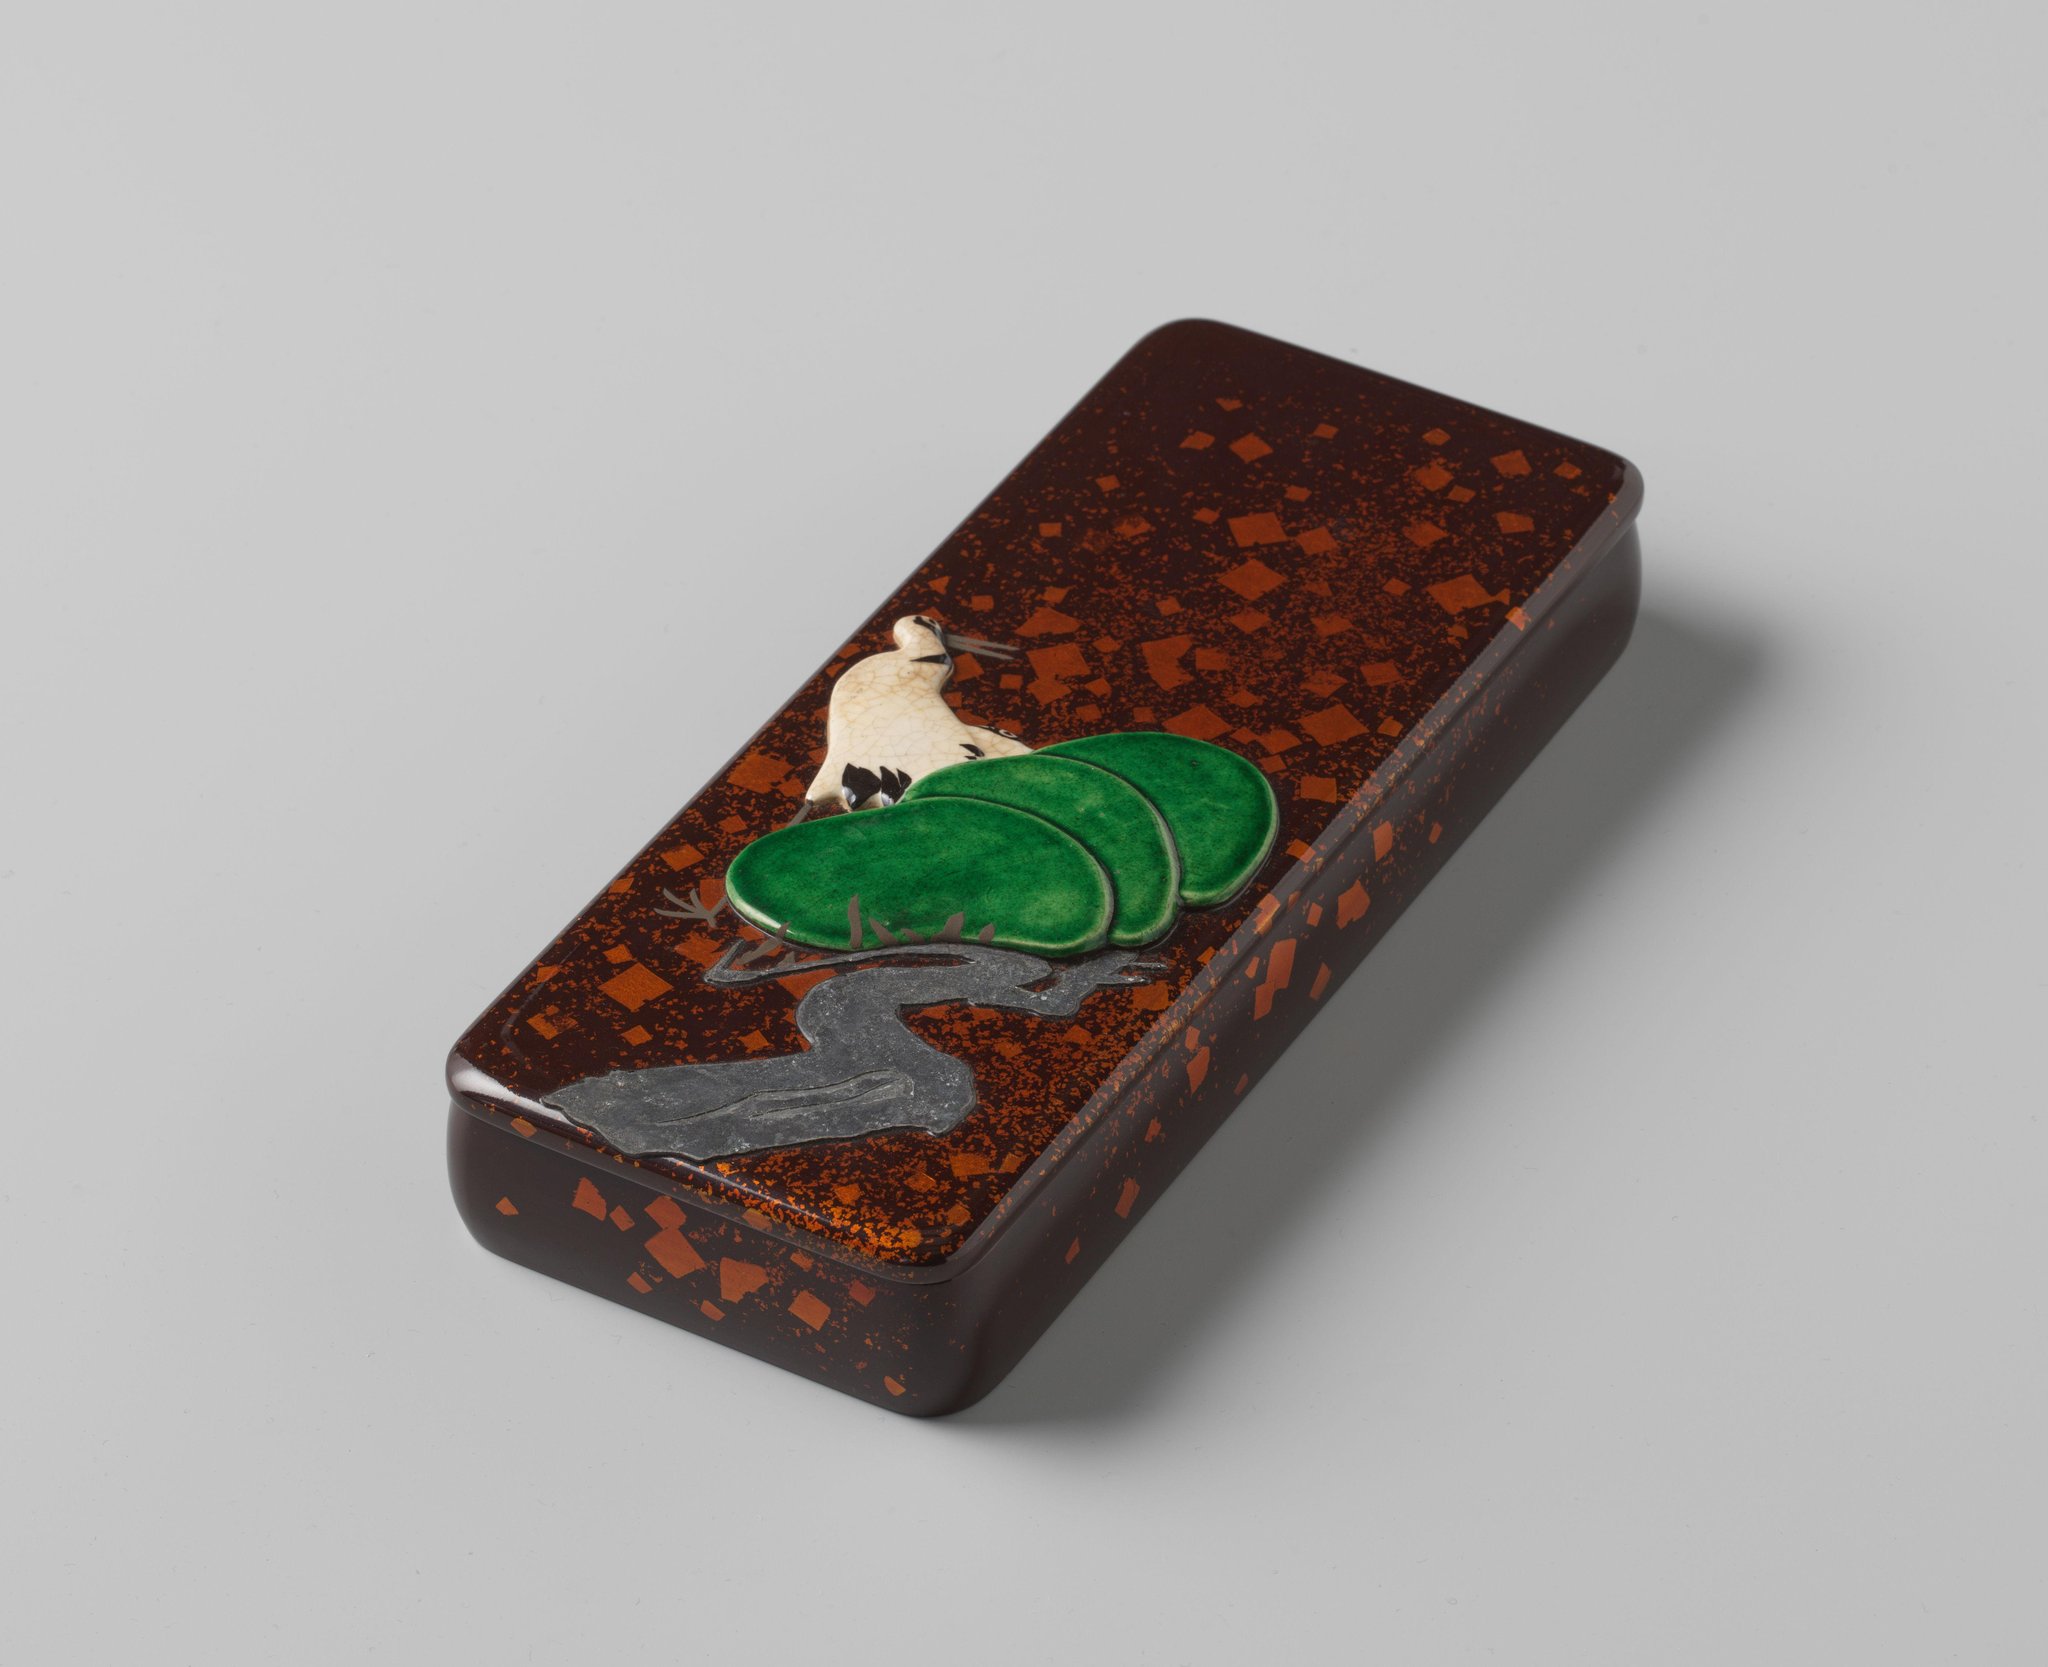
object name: schrijfdoos, schrijfcassette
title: Writing box ‘A Pair of Cranes in an Old Pine Tree’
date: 1910-1925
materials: lacquer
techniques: lacquer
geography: japan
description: This simple writing box with lead and ceramic inlay is characteristic of the style of the designer Kamisaka Sekka. For this box he worked together with the ceramicist Tozan and the lacquer master Hyoetsu. Such collaboration was common among Rinpa artists.